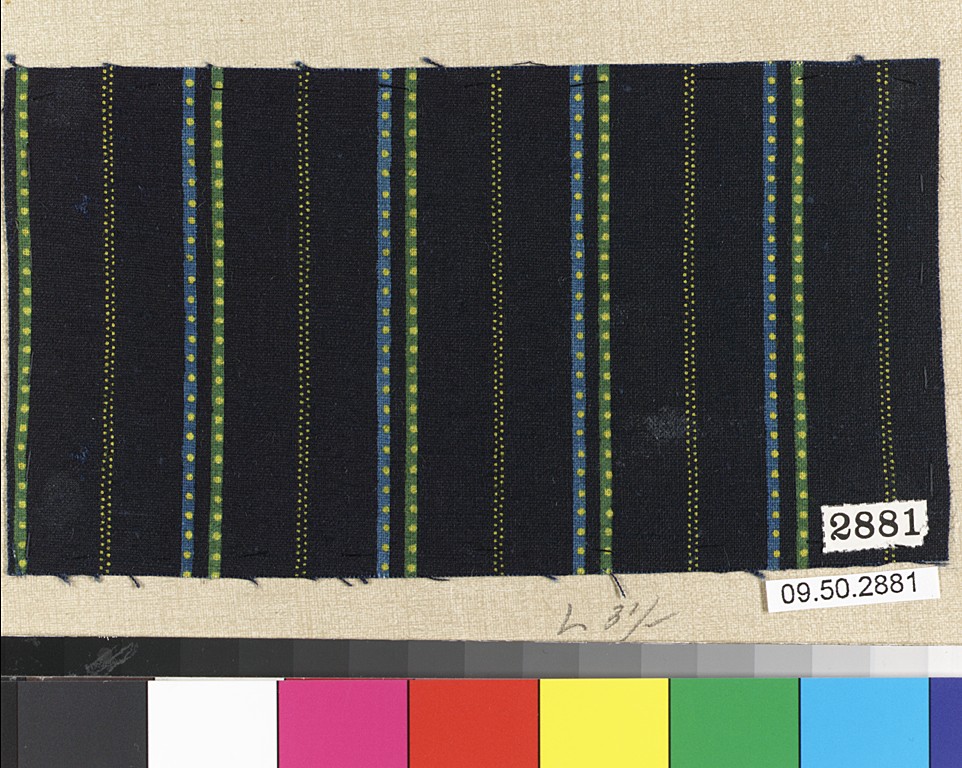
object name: piece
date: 1801-1900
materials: cotton